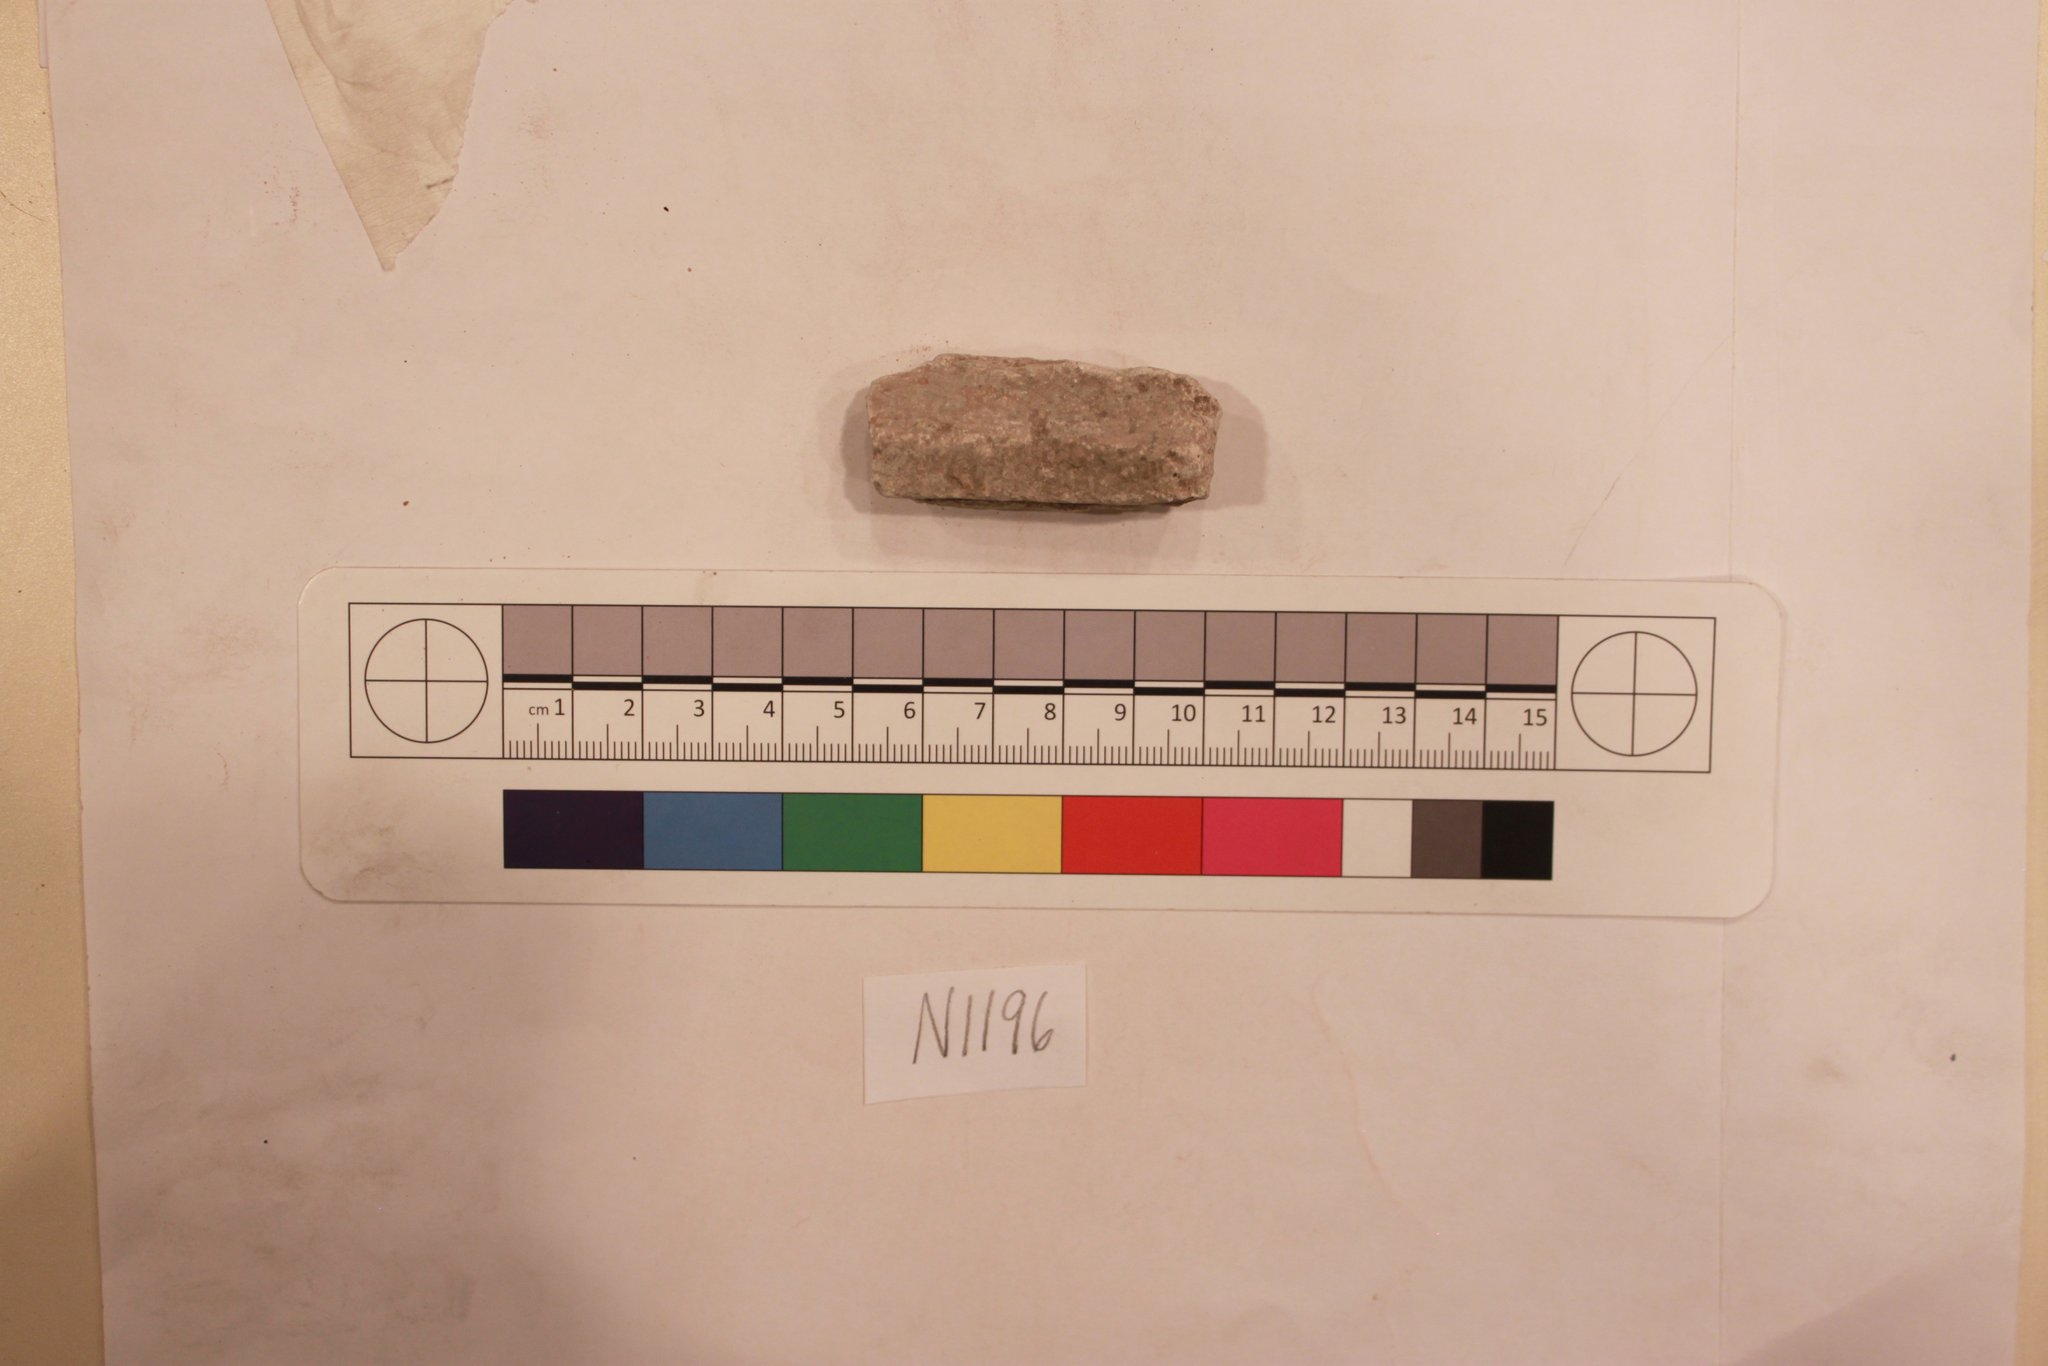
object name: fragment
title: Stucco Fragment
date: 701-1200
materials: plaster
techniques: carving, painting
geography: iran